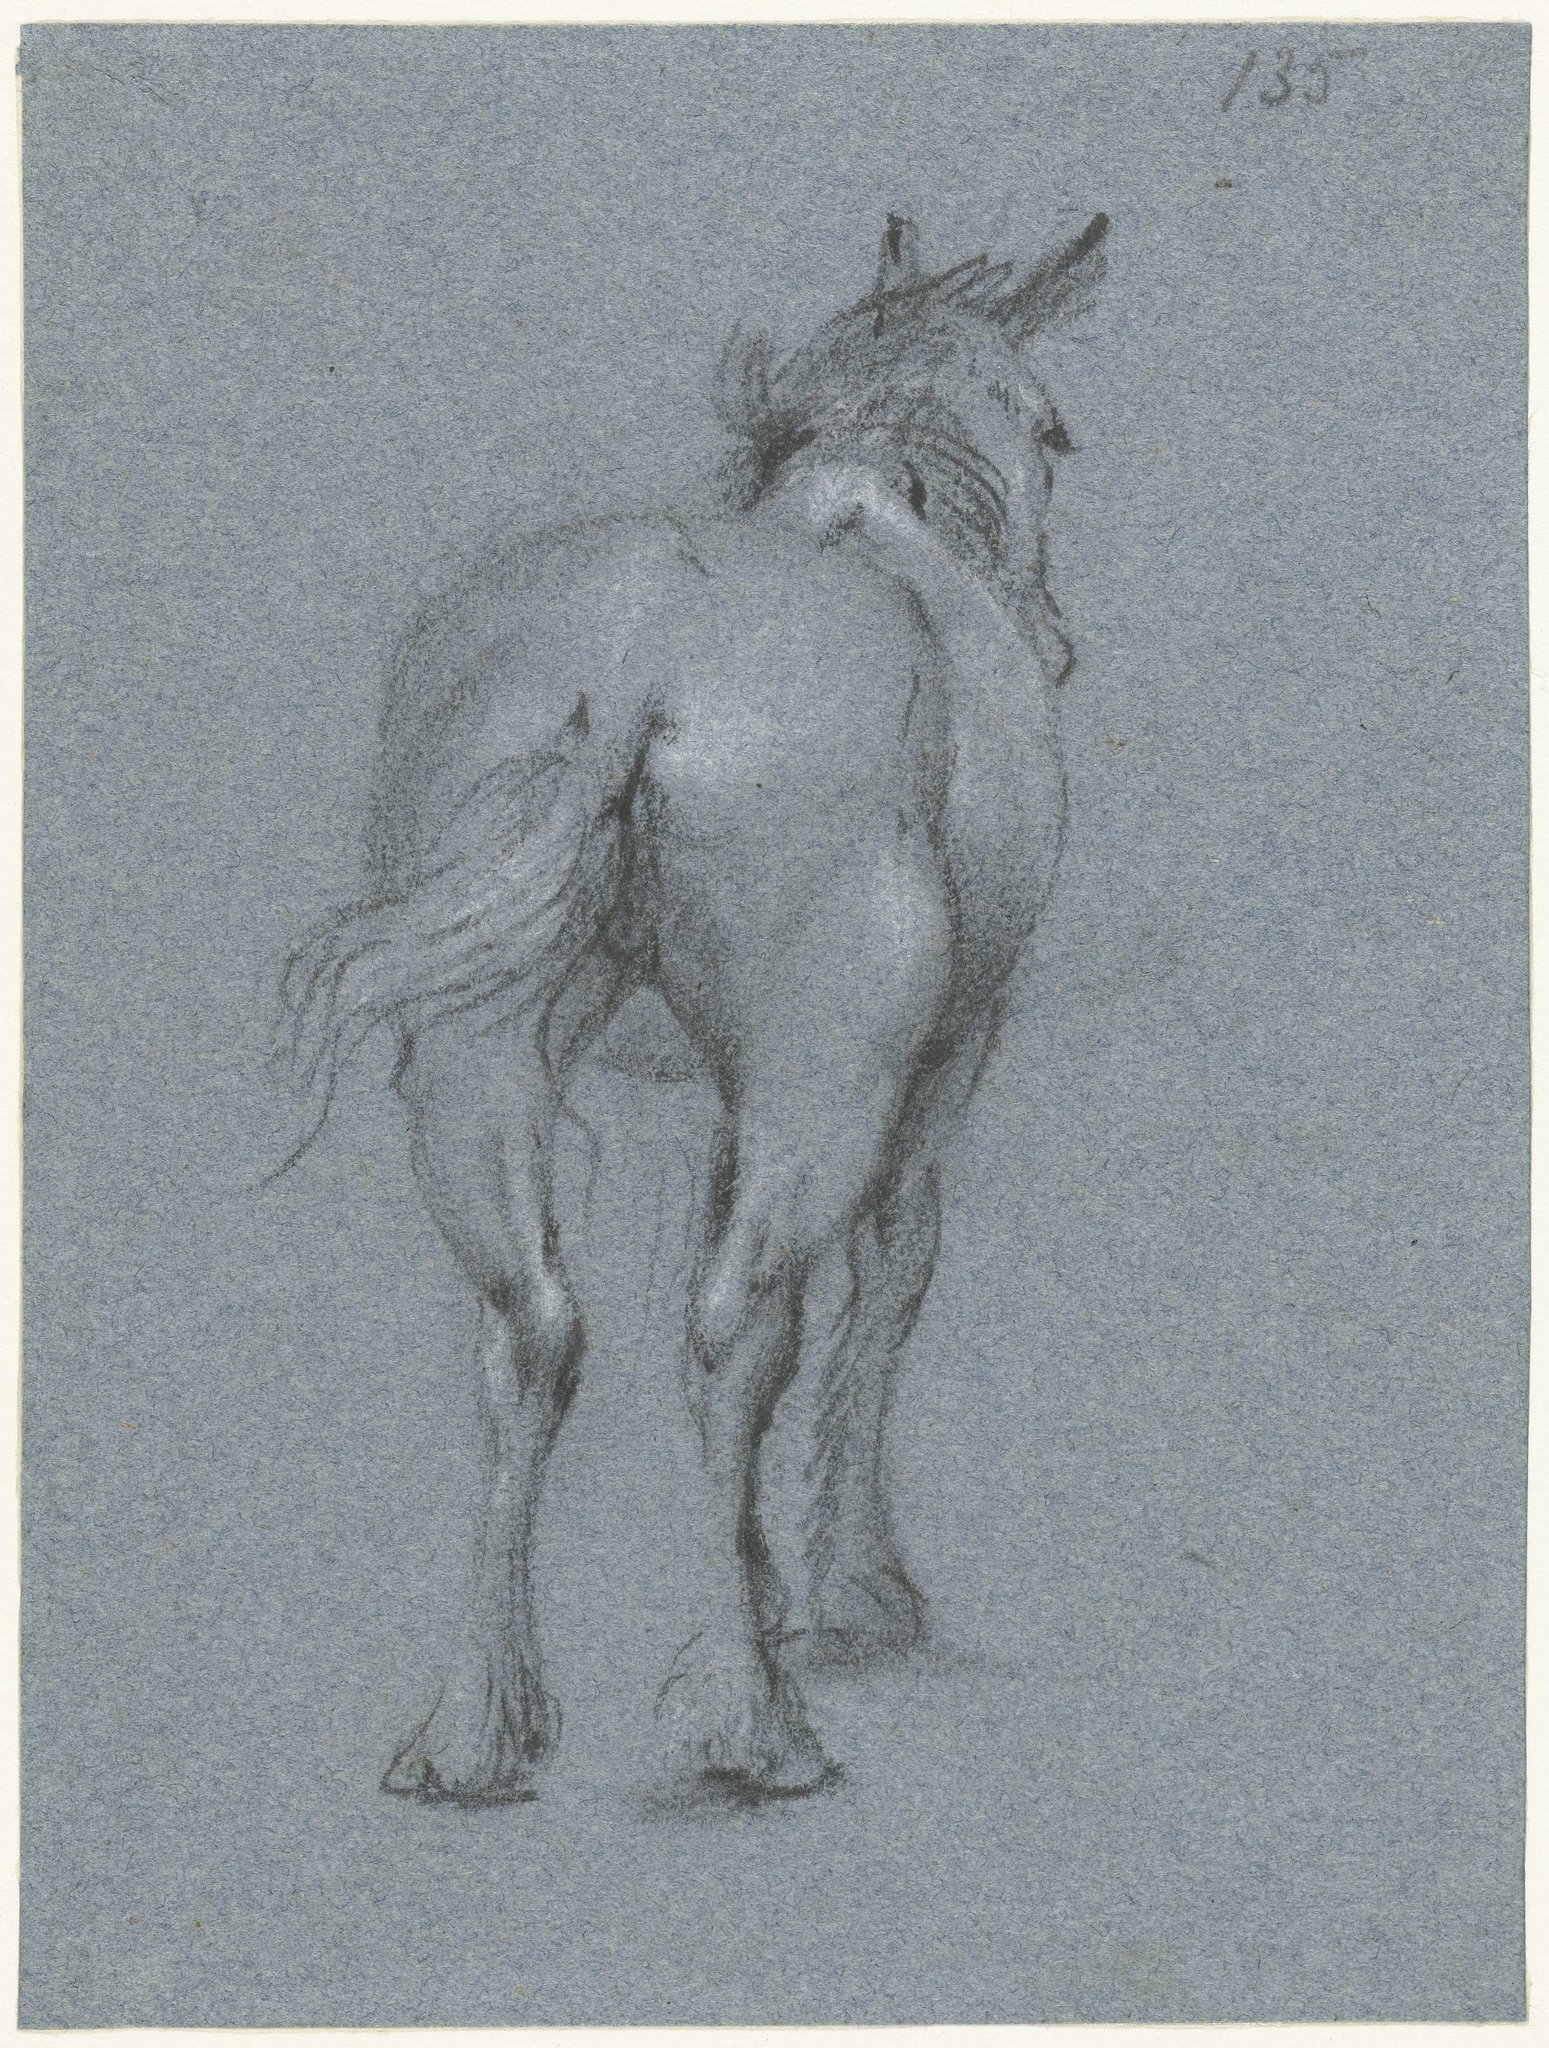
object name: drawing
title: Studie van een paard zwaaiend met zijn staart, van achteren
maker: moses ter borch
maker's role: draughtsman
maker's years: 1645-1667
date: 1660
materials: chalk, paper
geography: zwolle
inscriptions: annotation: ‘2’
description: Blad uit serie van 8 tekeningen van werkpaarden, waarschijnlijk naar het leven getekend.